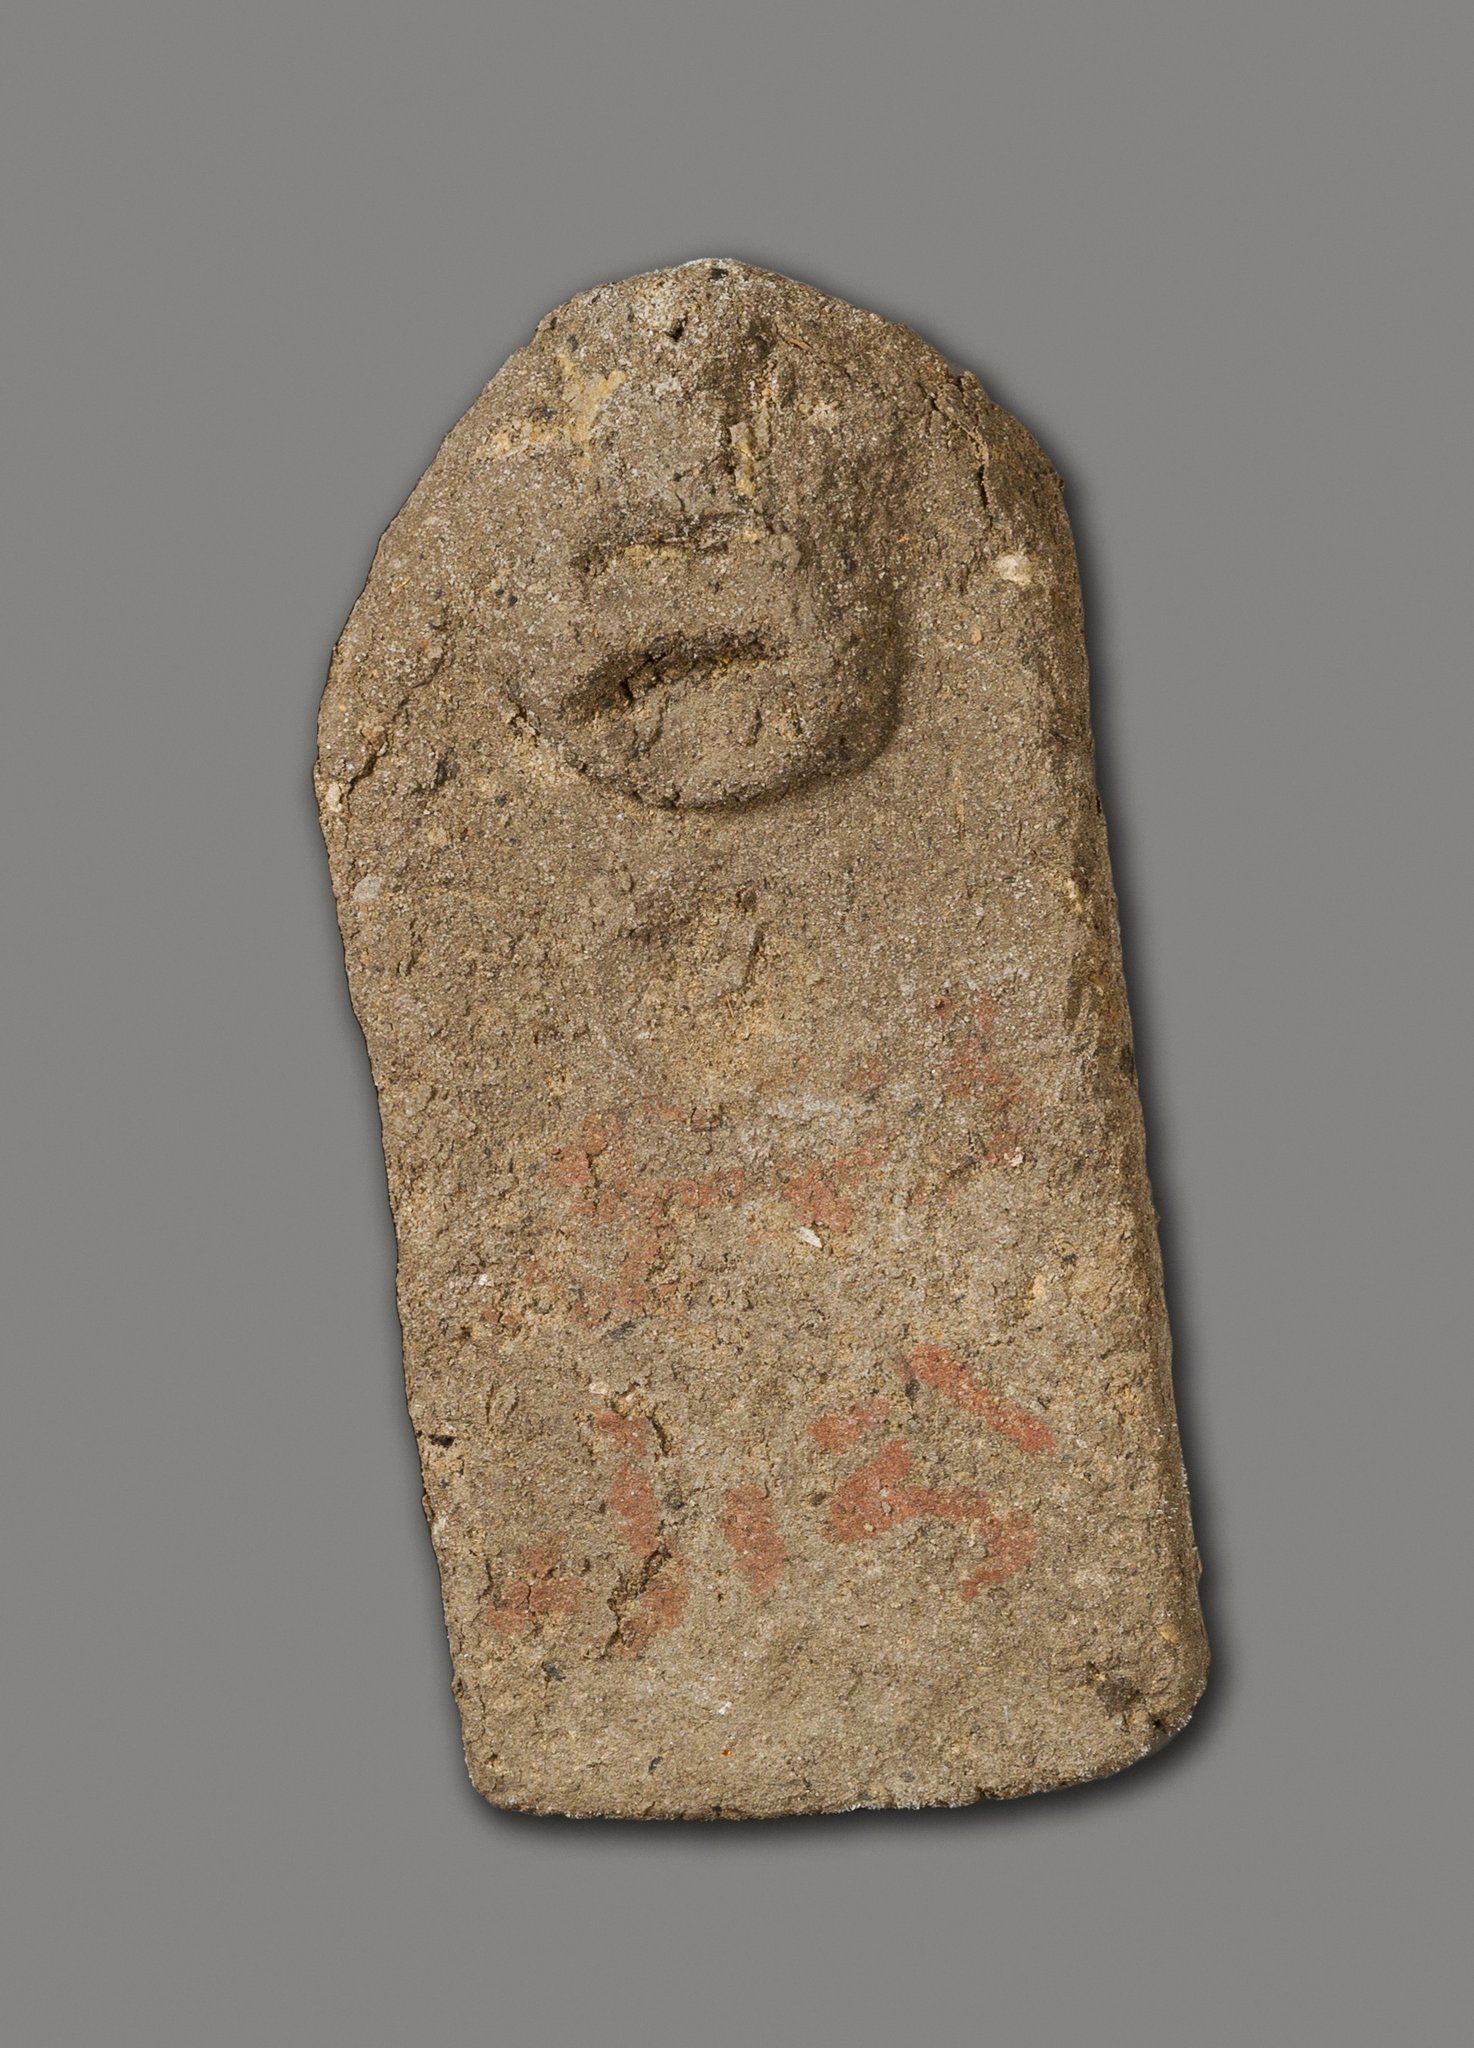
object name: figure, magical, execration, tablet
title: Magical Figure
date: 1802-1550 BCE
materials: clay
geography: egypt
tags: faces